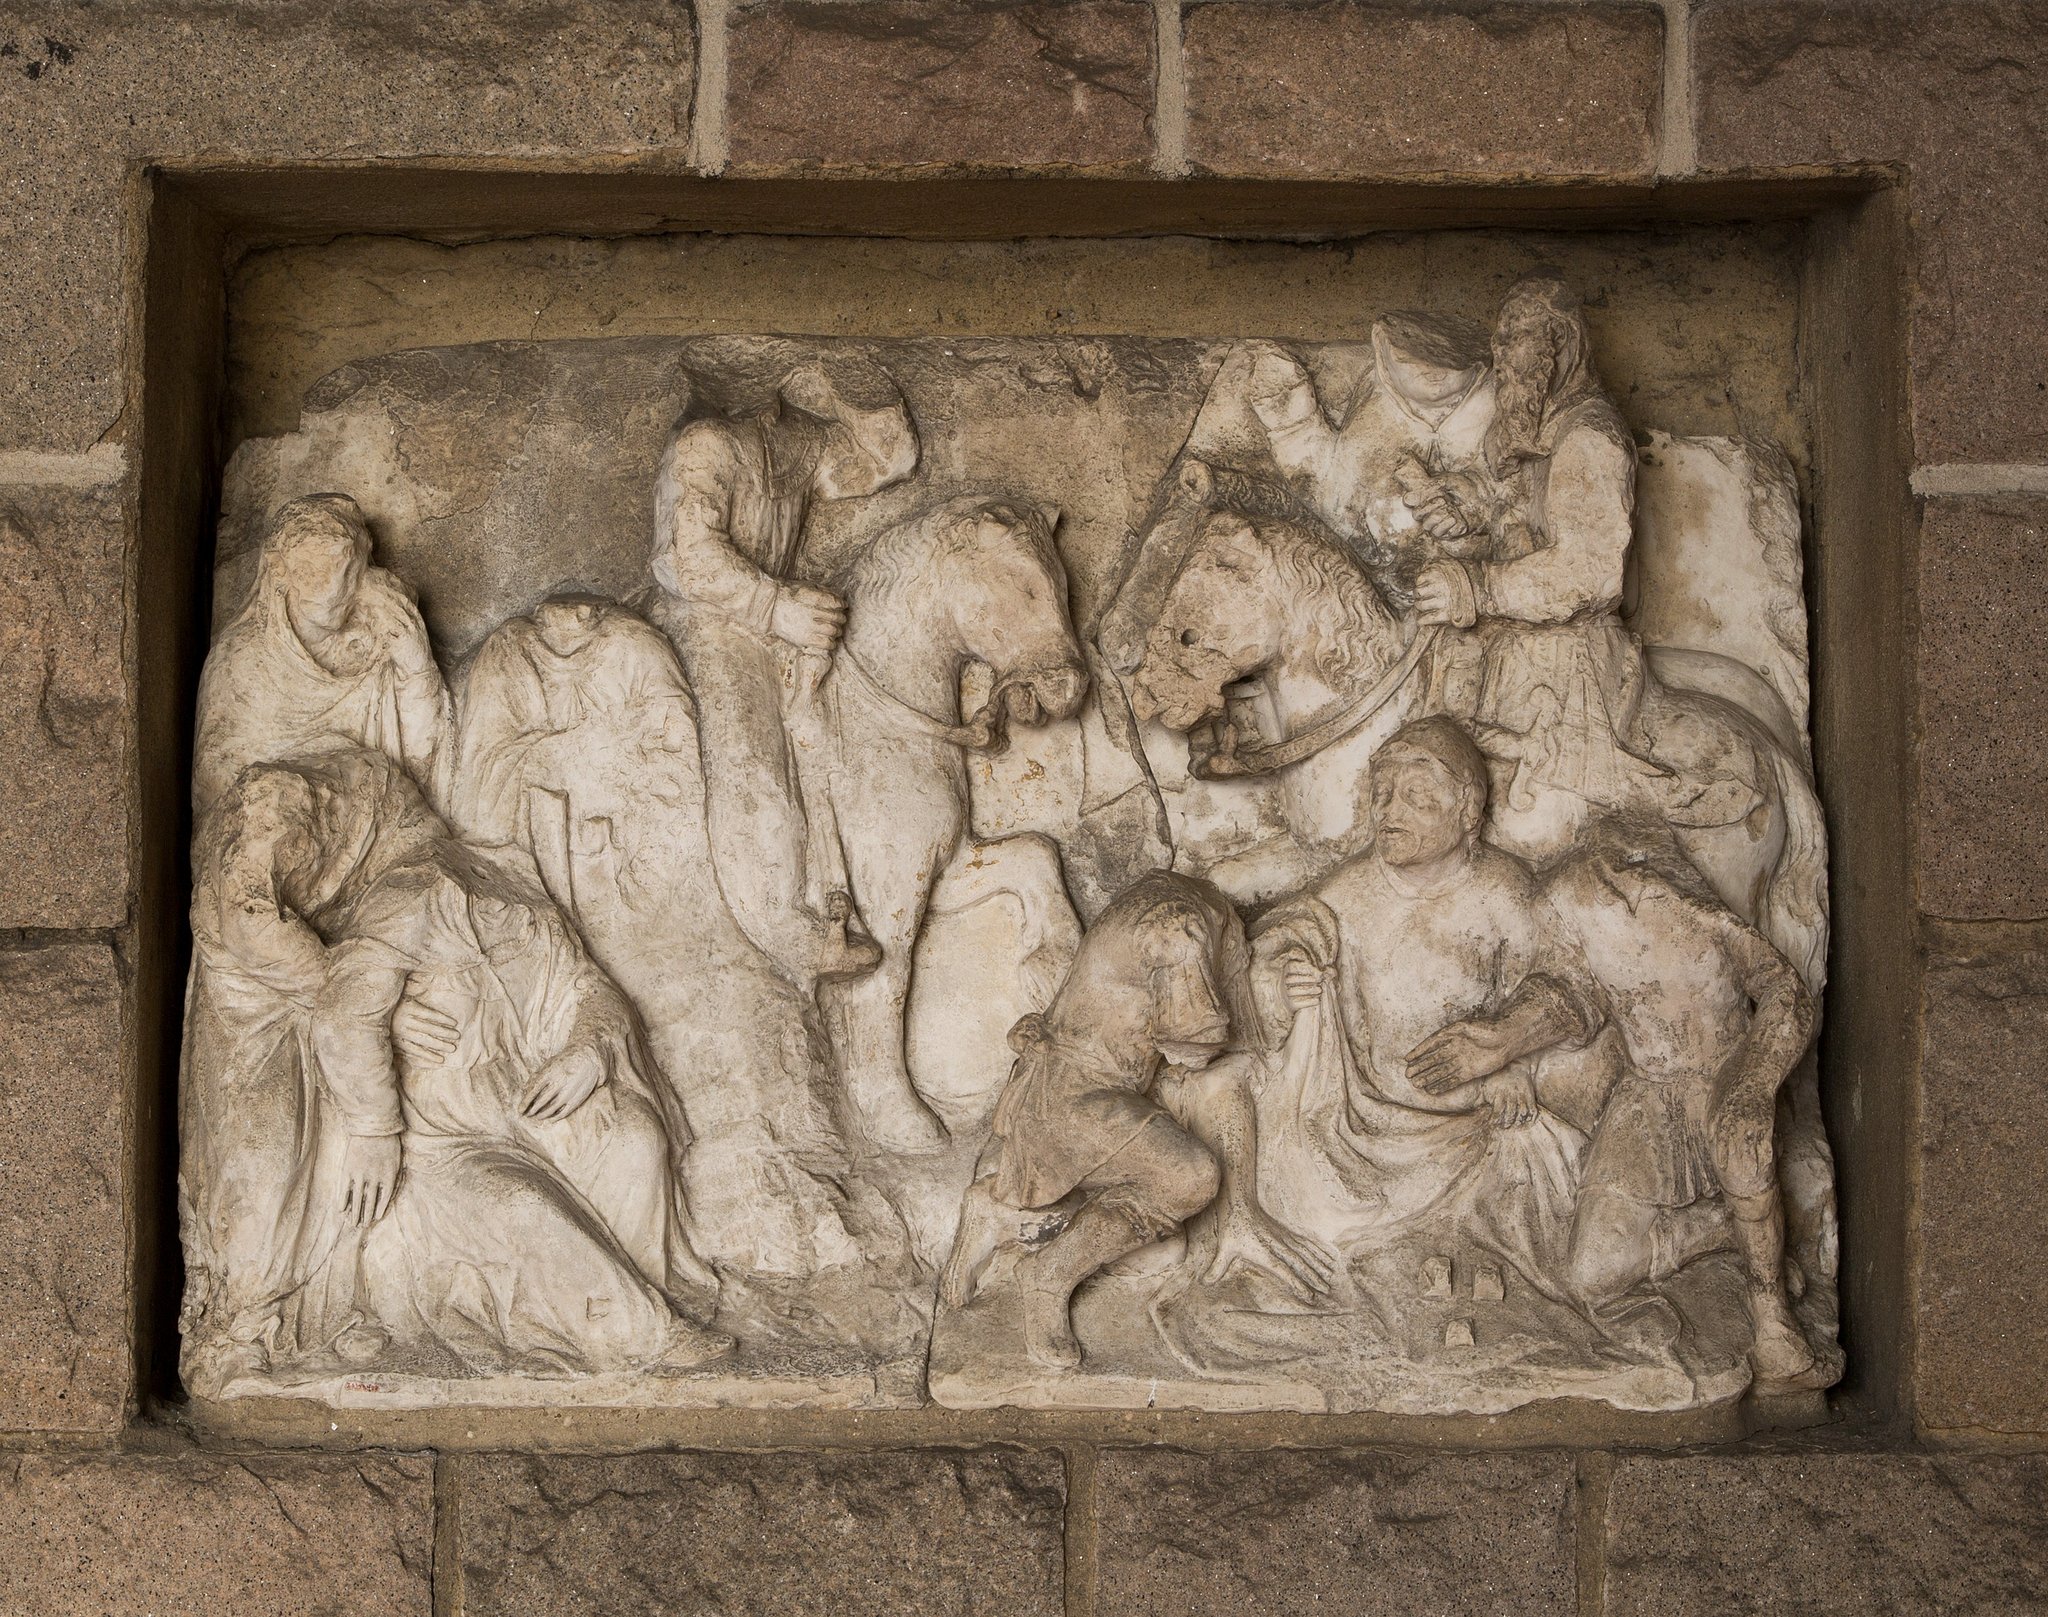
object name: relief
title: The Virgin Fainting and The Partition of the Garments (from Scenes from the Passion of Christ)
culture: french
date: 1501-1533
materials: stone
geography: france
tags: men,horses,virgin mary